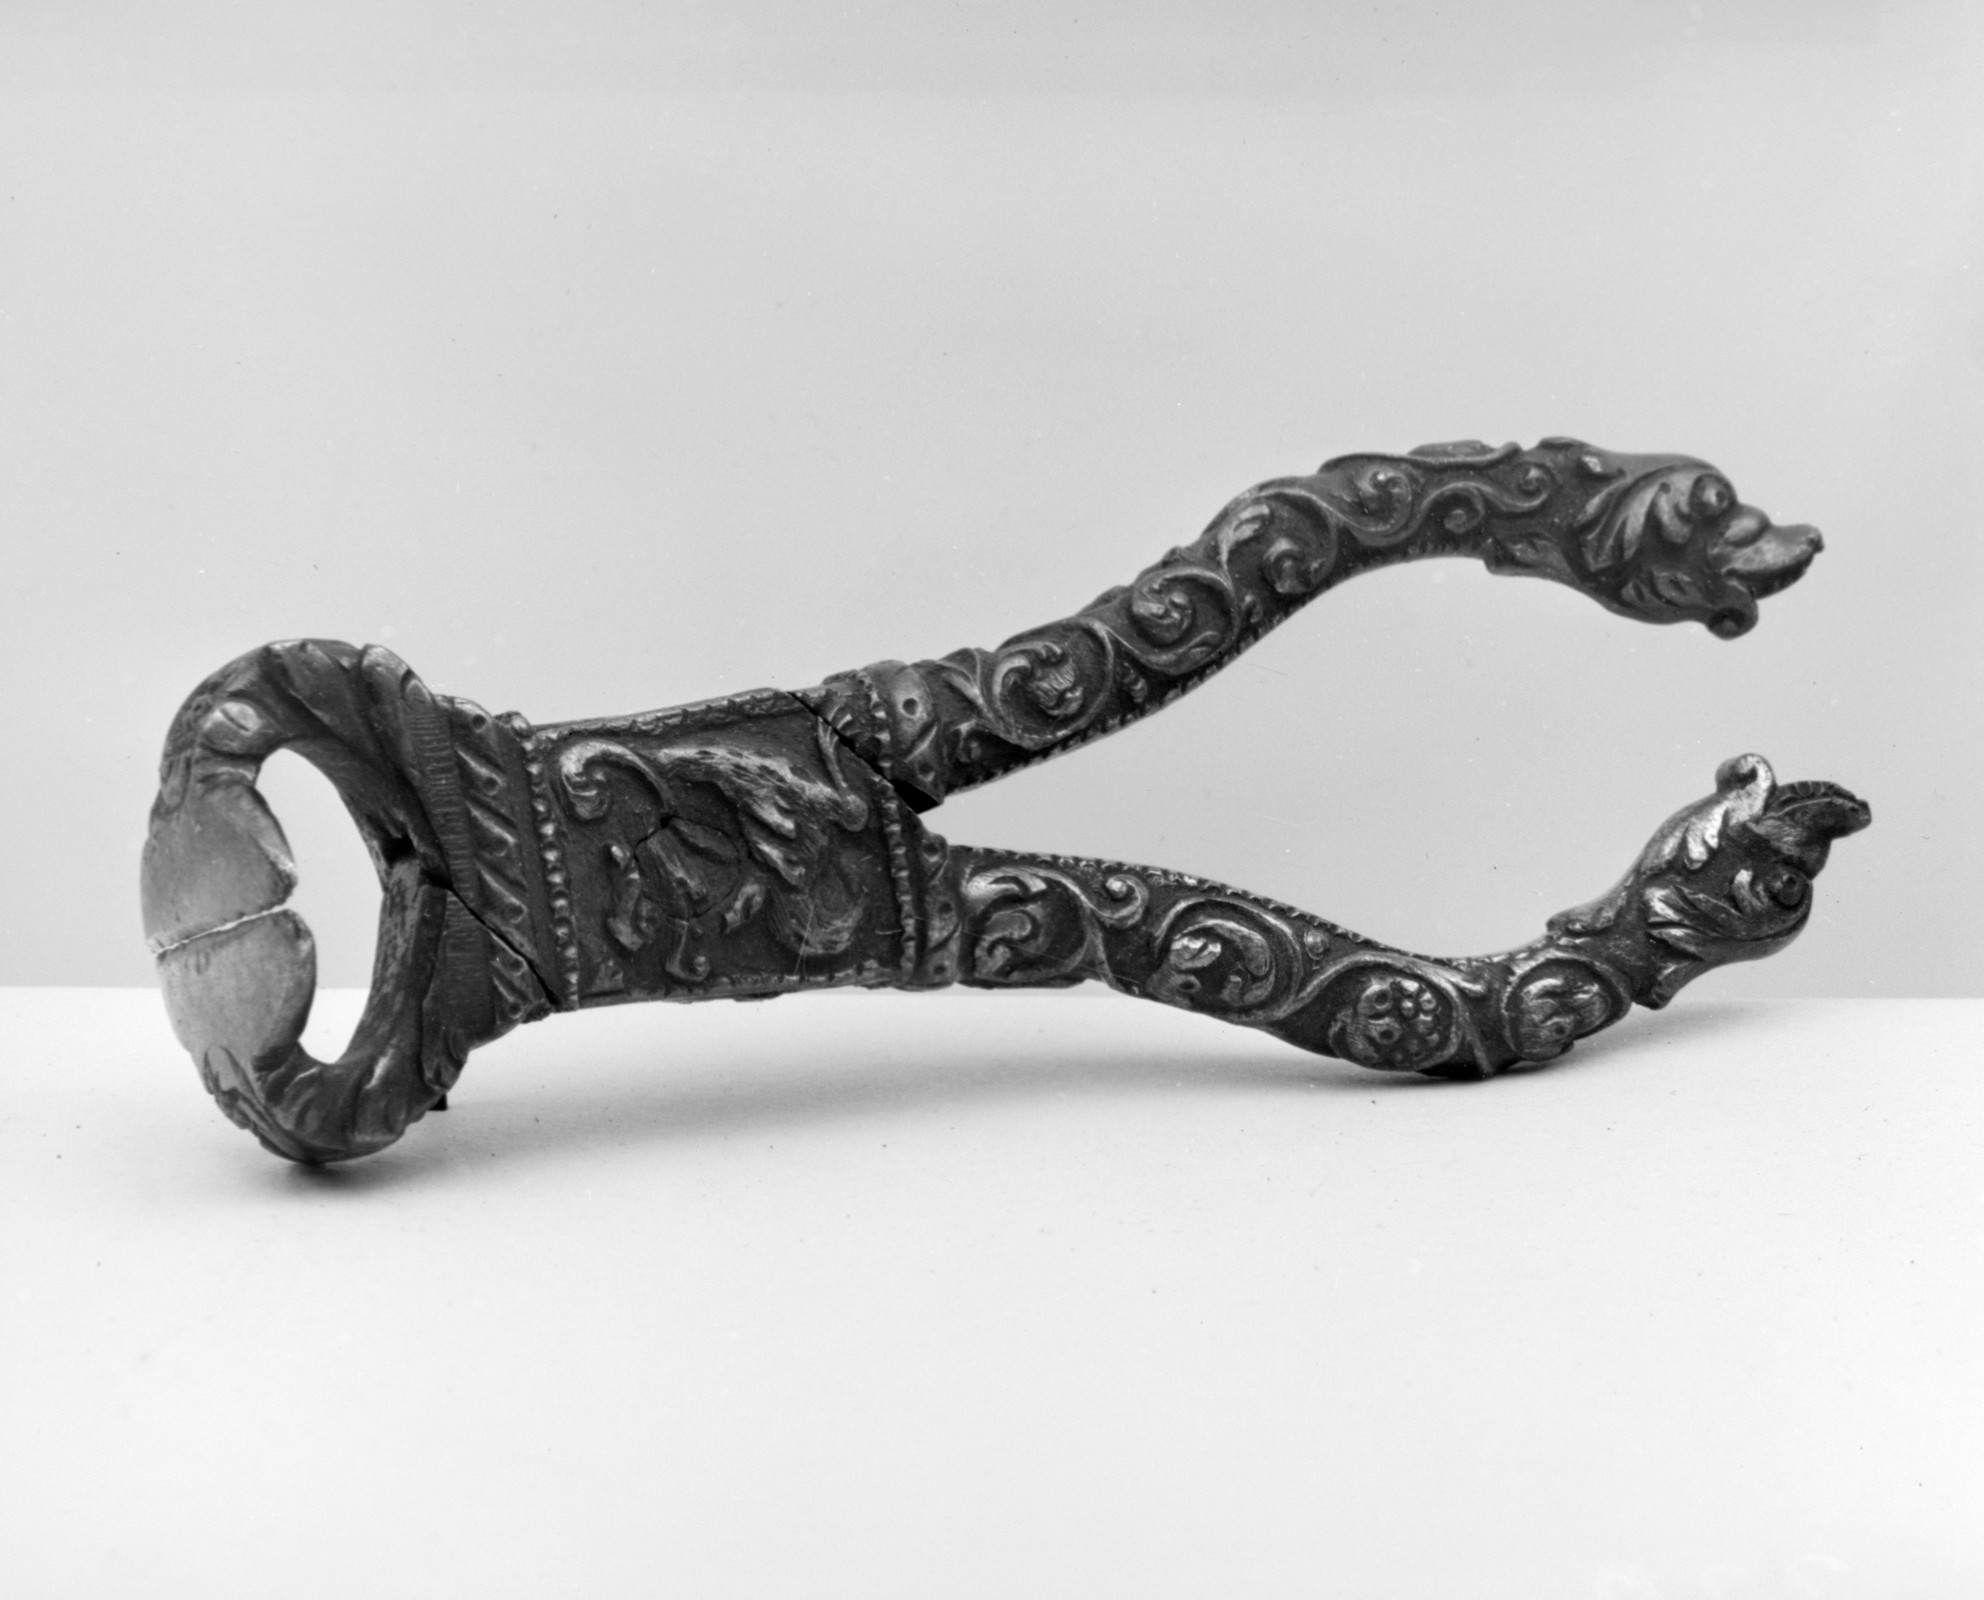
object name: clipper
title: Clippers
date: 1501-1600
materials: steel